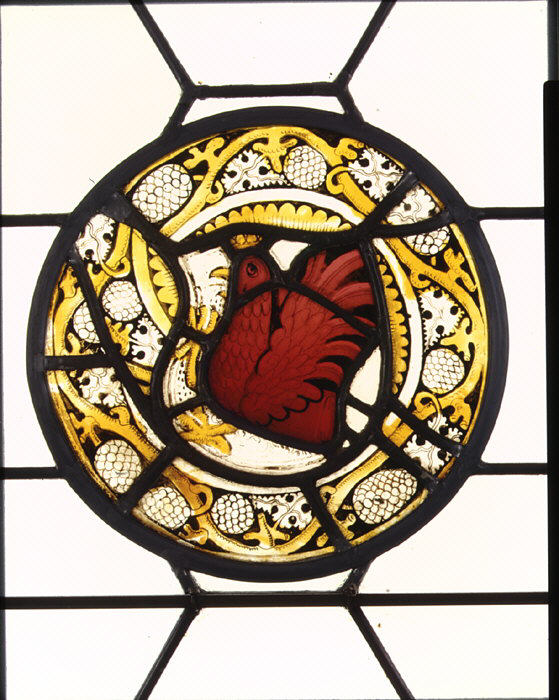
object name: roundel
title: Armorial Roundel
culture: german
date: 1500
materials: glass, metal, paint, pigment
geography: germany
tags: coat of arms